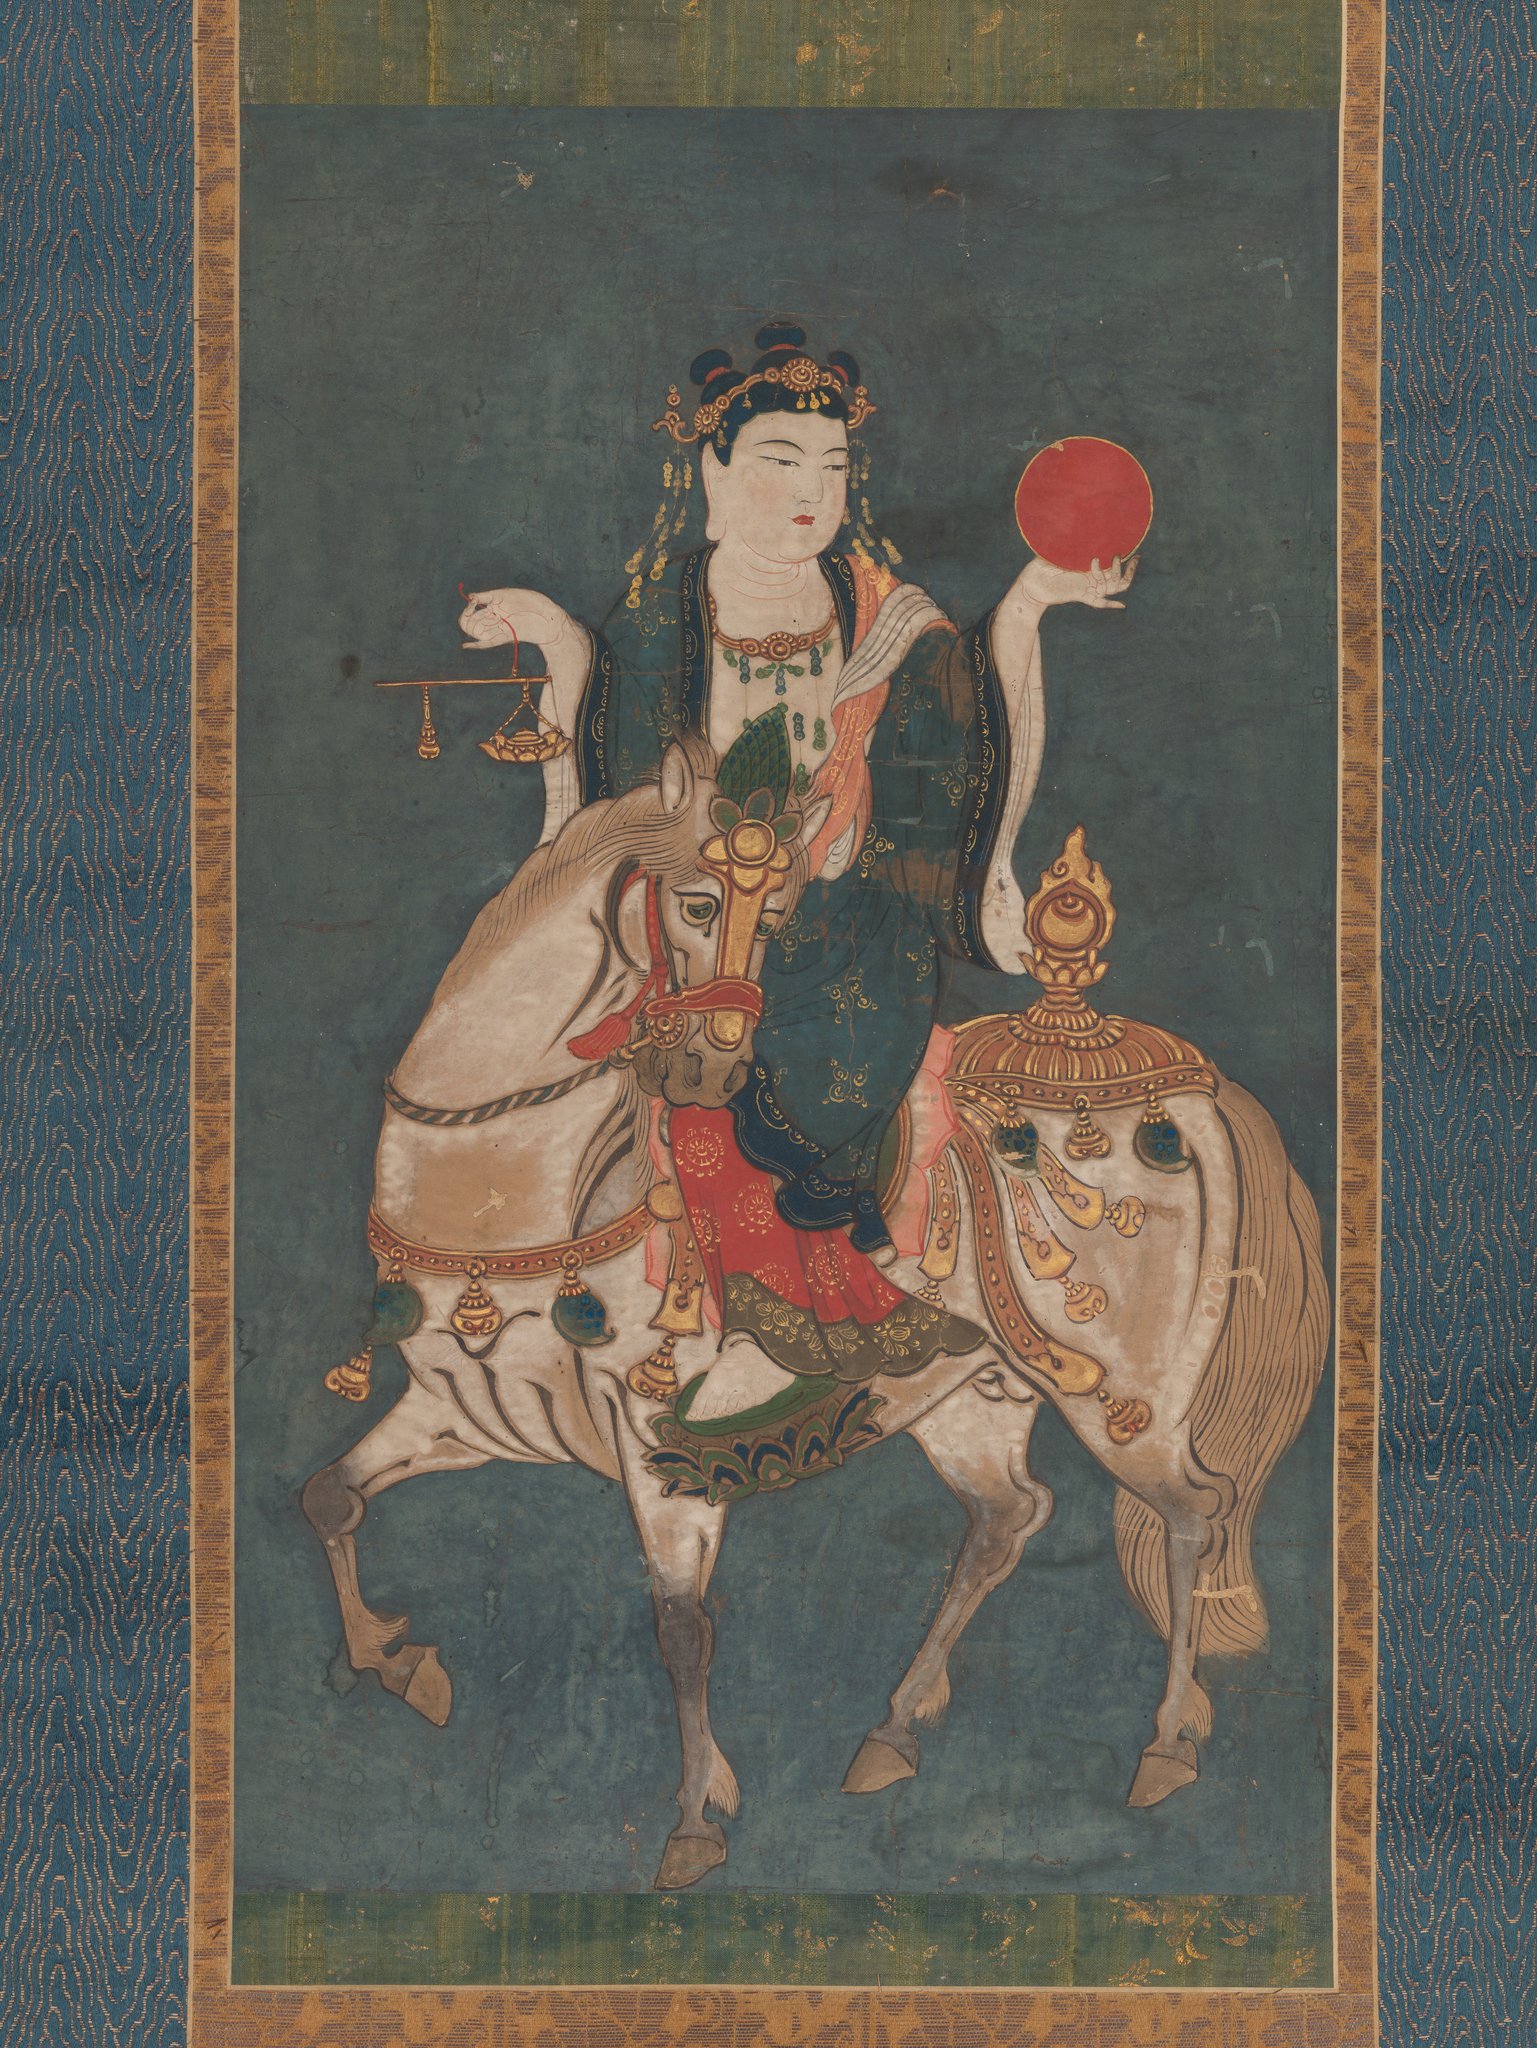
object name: hanging scroll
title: Memyō Bosatsu (Ashvaghosha Bodhisattva) Mounted on a Horse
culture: japanese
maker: unidentified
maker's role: artist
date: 1401-1600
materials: gold, ink, paper